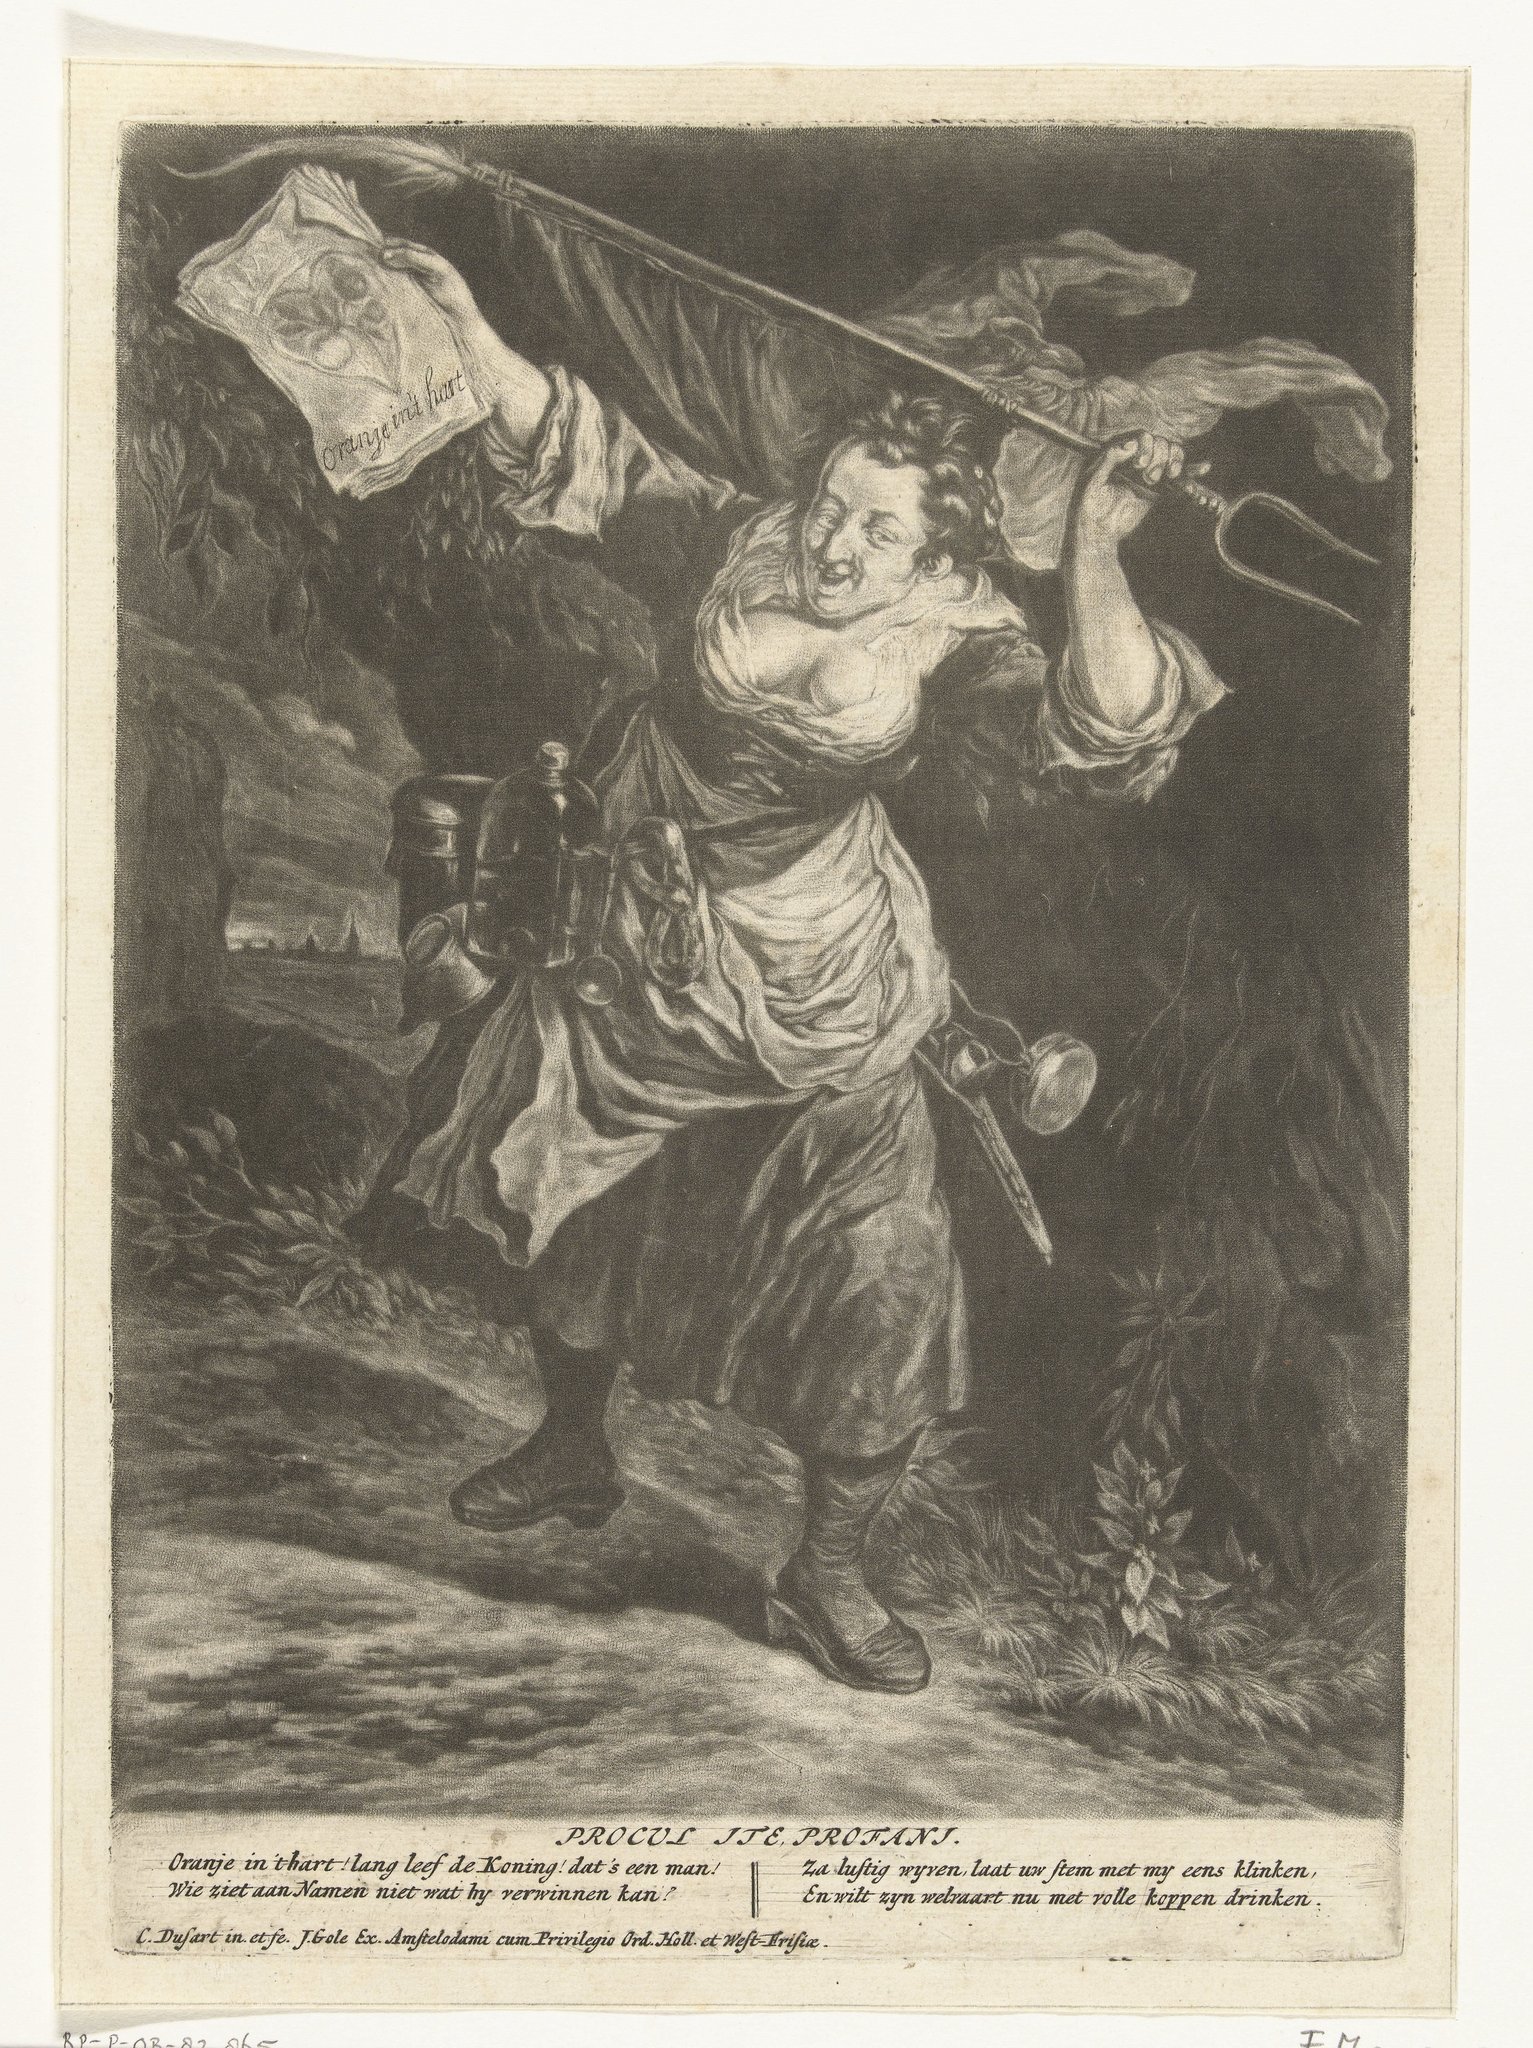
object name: print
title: De Orangiste, 1695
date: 1695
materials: paper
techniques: mezzotint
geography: amsterdam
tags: the hague, william iii (prince of orange and king of england, scotland, and ireland), festivities on events of national importance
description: De Orangiste. Dansende vrouw met in de hand een orangistisch pamflet. Onder de voorstelling een Latijnse titel en een Nederlands vers van vier regels. Onderdeel van een reeks van acht prenten vervaardigd naar aanleiding van de verovering van Namen door de geallieerden op 5 september 1695.